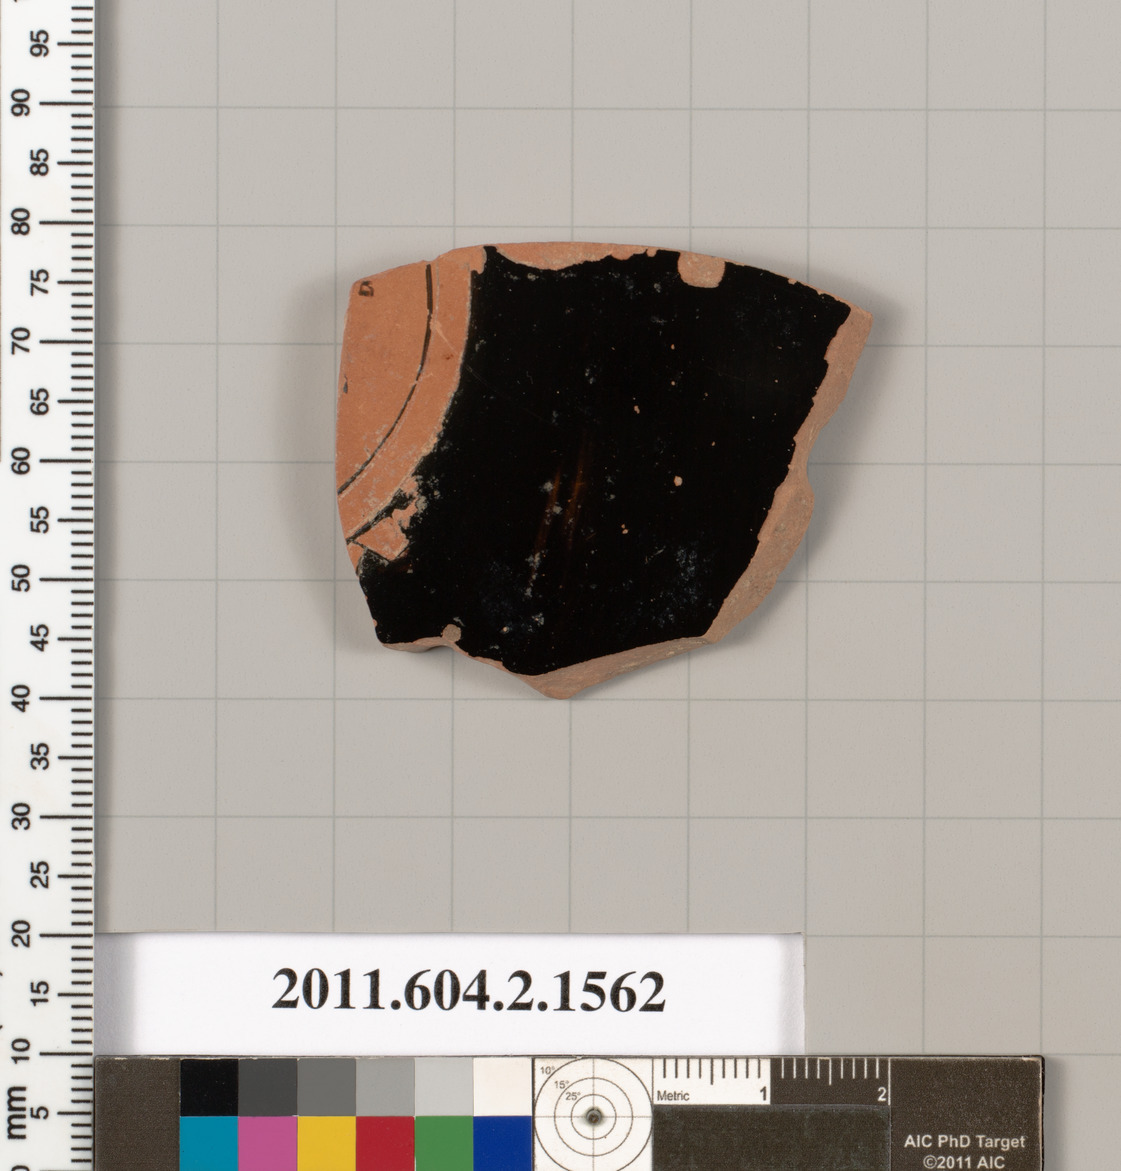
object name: skyphos fragment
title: Terracotta fragment of a skyphos (deep drinking cup)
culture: greek, attic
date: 460-440 BCE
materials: terracotta